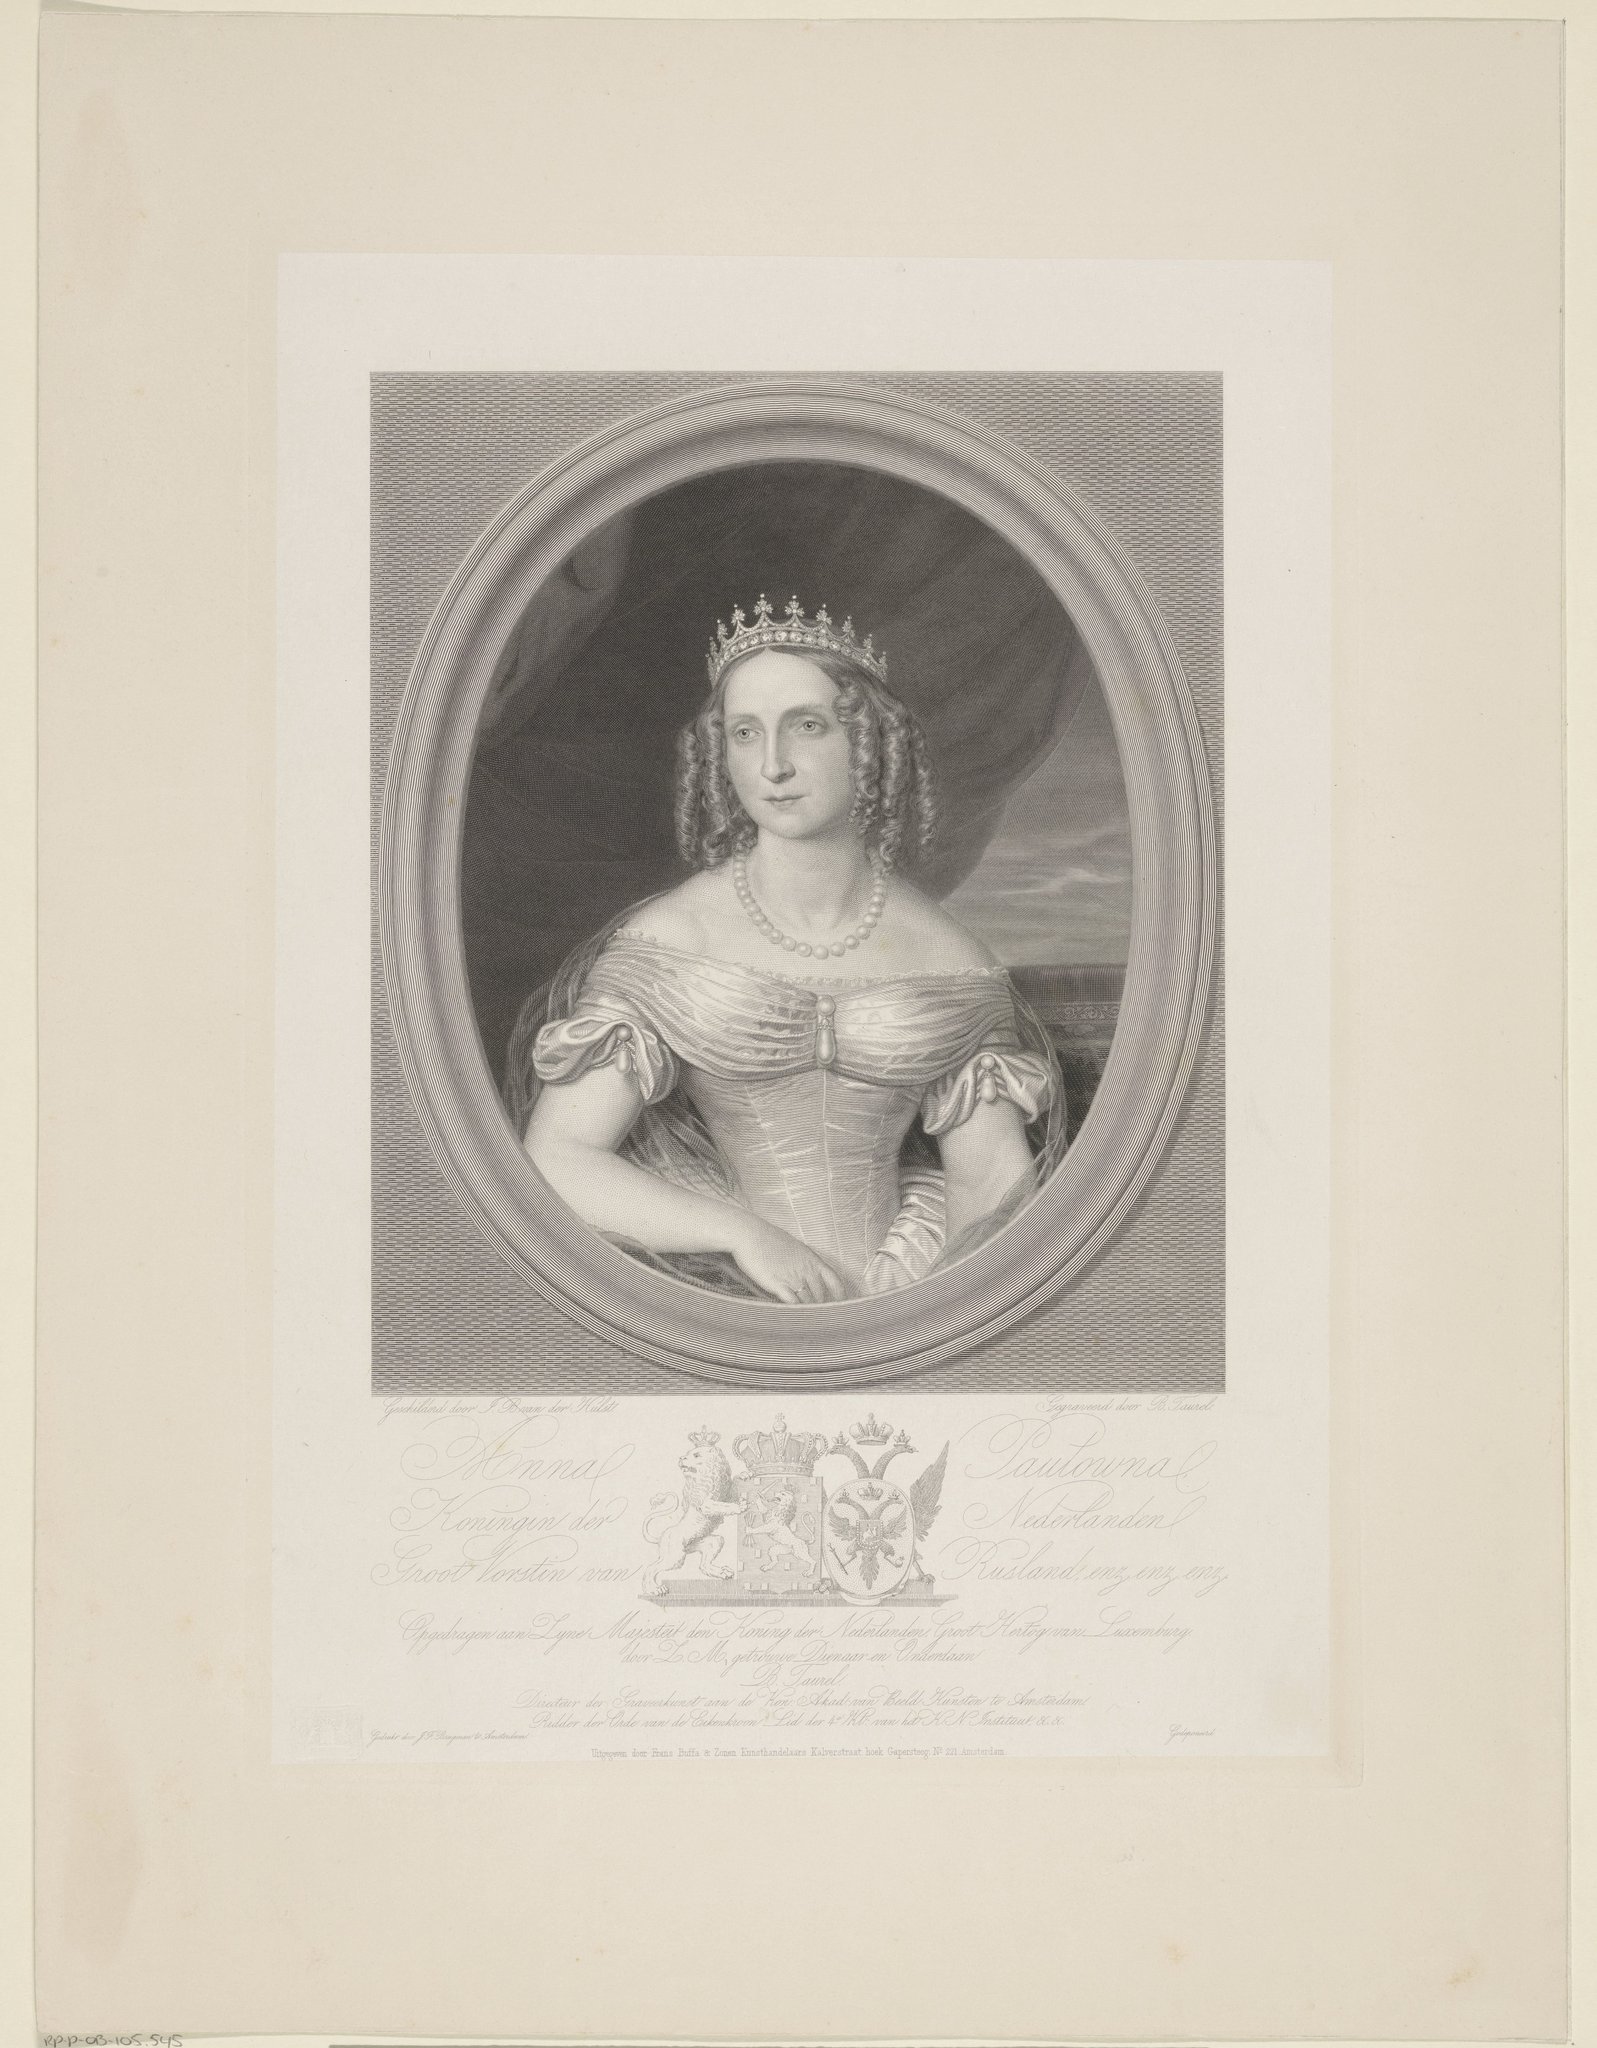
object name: print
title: Portret van Anna Paulowna Romanowa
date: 1846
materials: paper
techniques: engraving, etching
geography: amsterdam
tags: anna paulowna romanowa, the hague, william ii of the netherlands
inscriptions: collector's mark: Lugt 12, check stamp: ‘François Buffa & Fils’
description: Portret van Anna Paulowna in een ovaal. Midden onder haar wapen en het wapen van Willem II met twee kronen, een leeuw en een tweekoppige adelaar. In de ondermarge haar naam en titels.